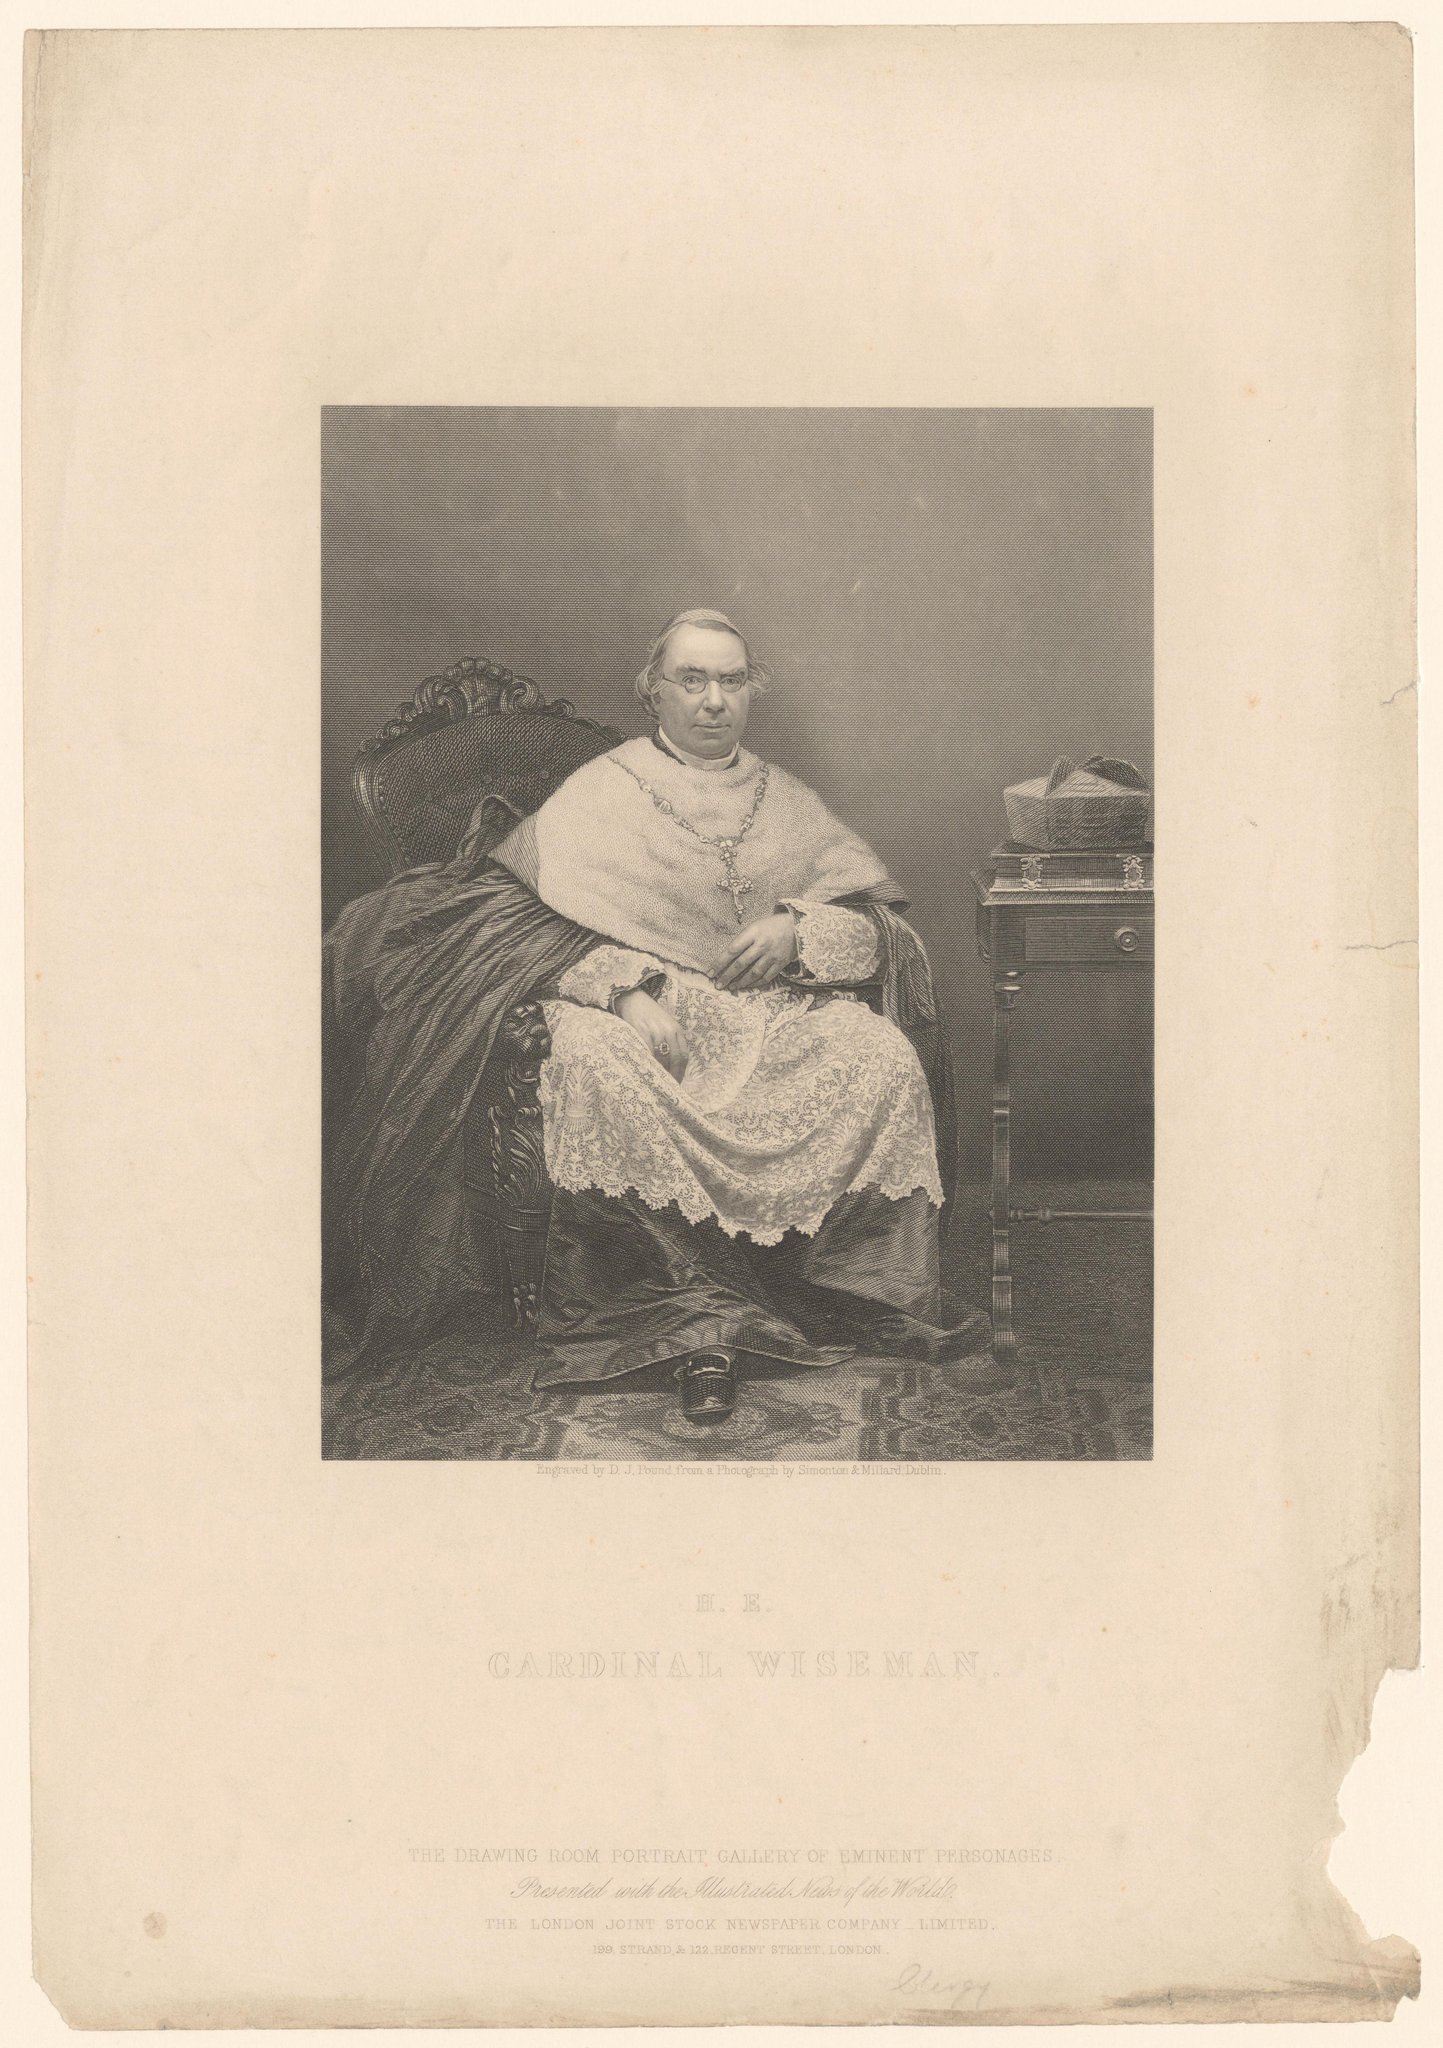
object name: print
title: H.E. Cardinal Wiseman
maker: daniel john pound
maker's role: print maker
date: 1859-1862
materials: paper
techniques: engraving, etching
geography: dublin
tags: sevilla, cardinal, historical persons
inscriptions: collector's mark: Lugt 2228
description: Prent uit: The drawing-room portrait gallery of eminent personages. Londen: London Joint Stock Newspaper Company, 1859-1862.